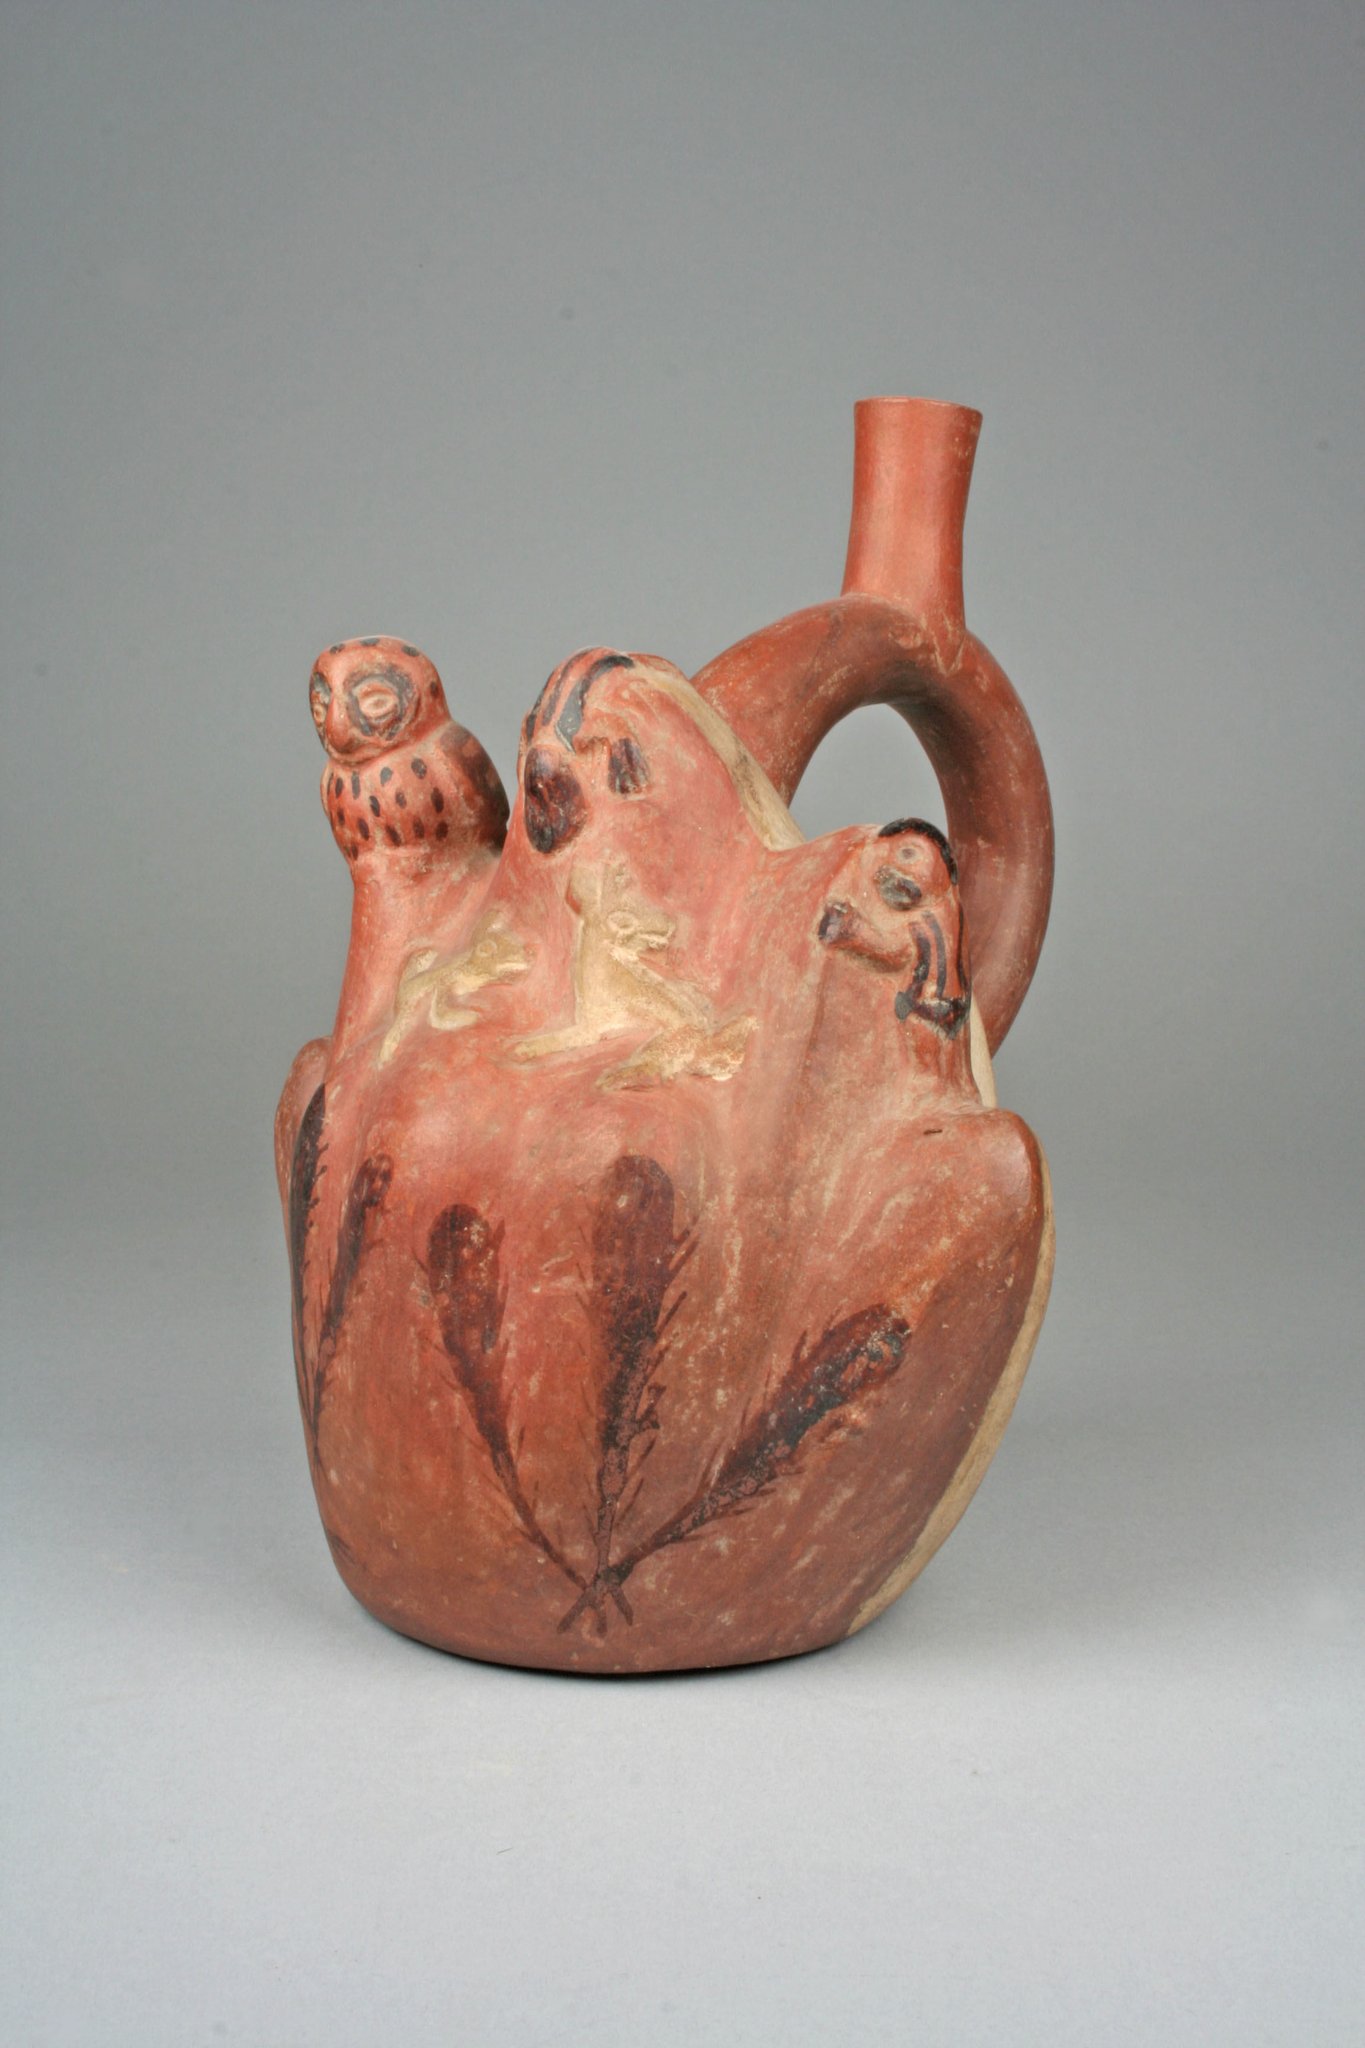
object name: bottle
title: Mountain Scene Bottle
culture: moche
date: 301-700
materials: ceramic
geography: peru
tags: animals,owls